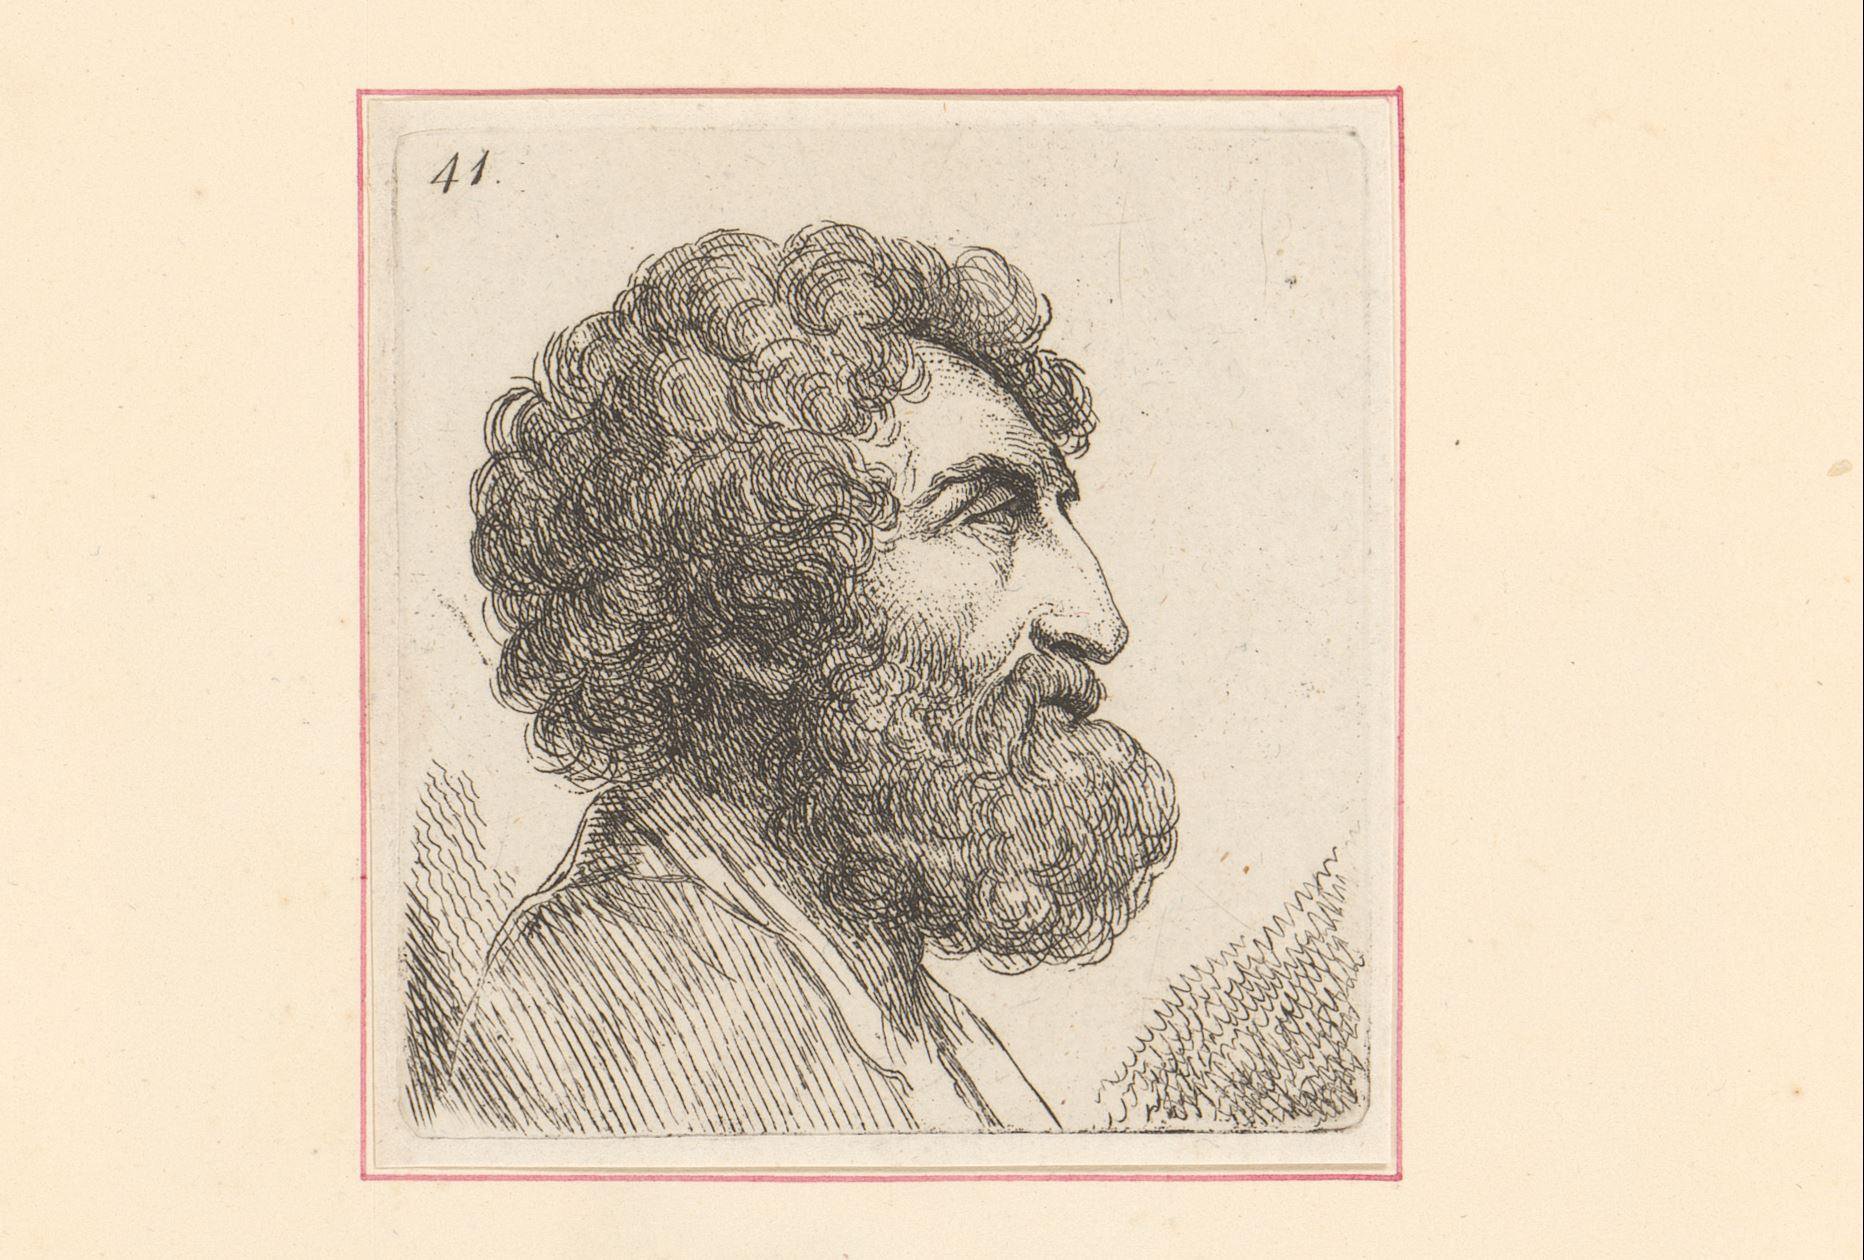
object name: album leaf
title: Hoofd van een onbekende man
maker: edward edwards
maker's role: painter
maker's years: 1738-1806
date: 1748-1806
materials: paper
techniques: etching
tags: head (human), adult man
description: Prent maakt deel uit van een serie van 51 prenten, bestaande uit twee delen met landschappen (36 prenten) en figuren en portretten (15 prenten), voor het eerst uitgegeven in Londen in 1790.